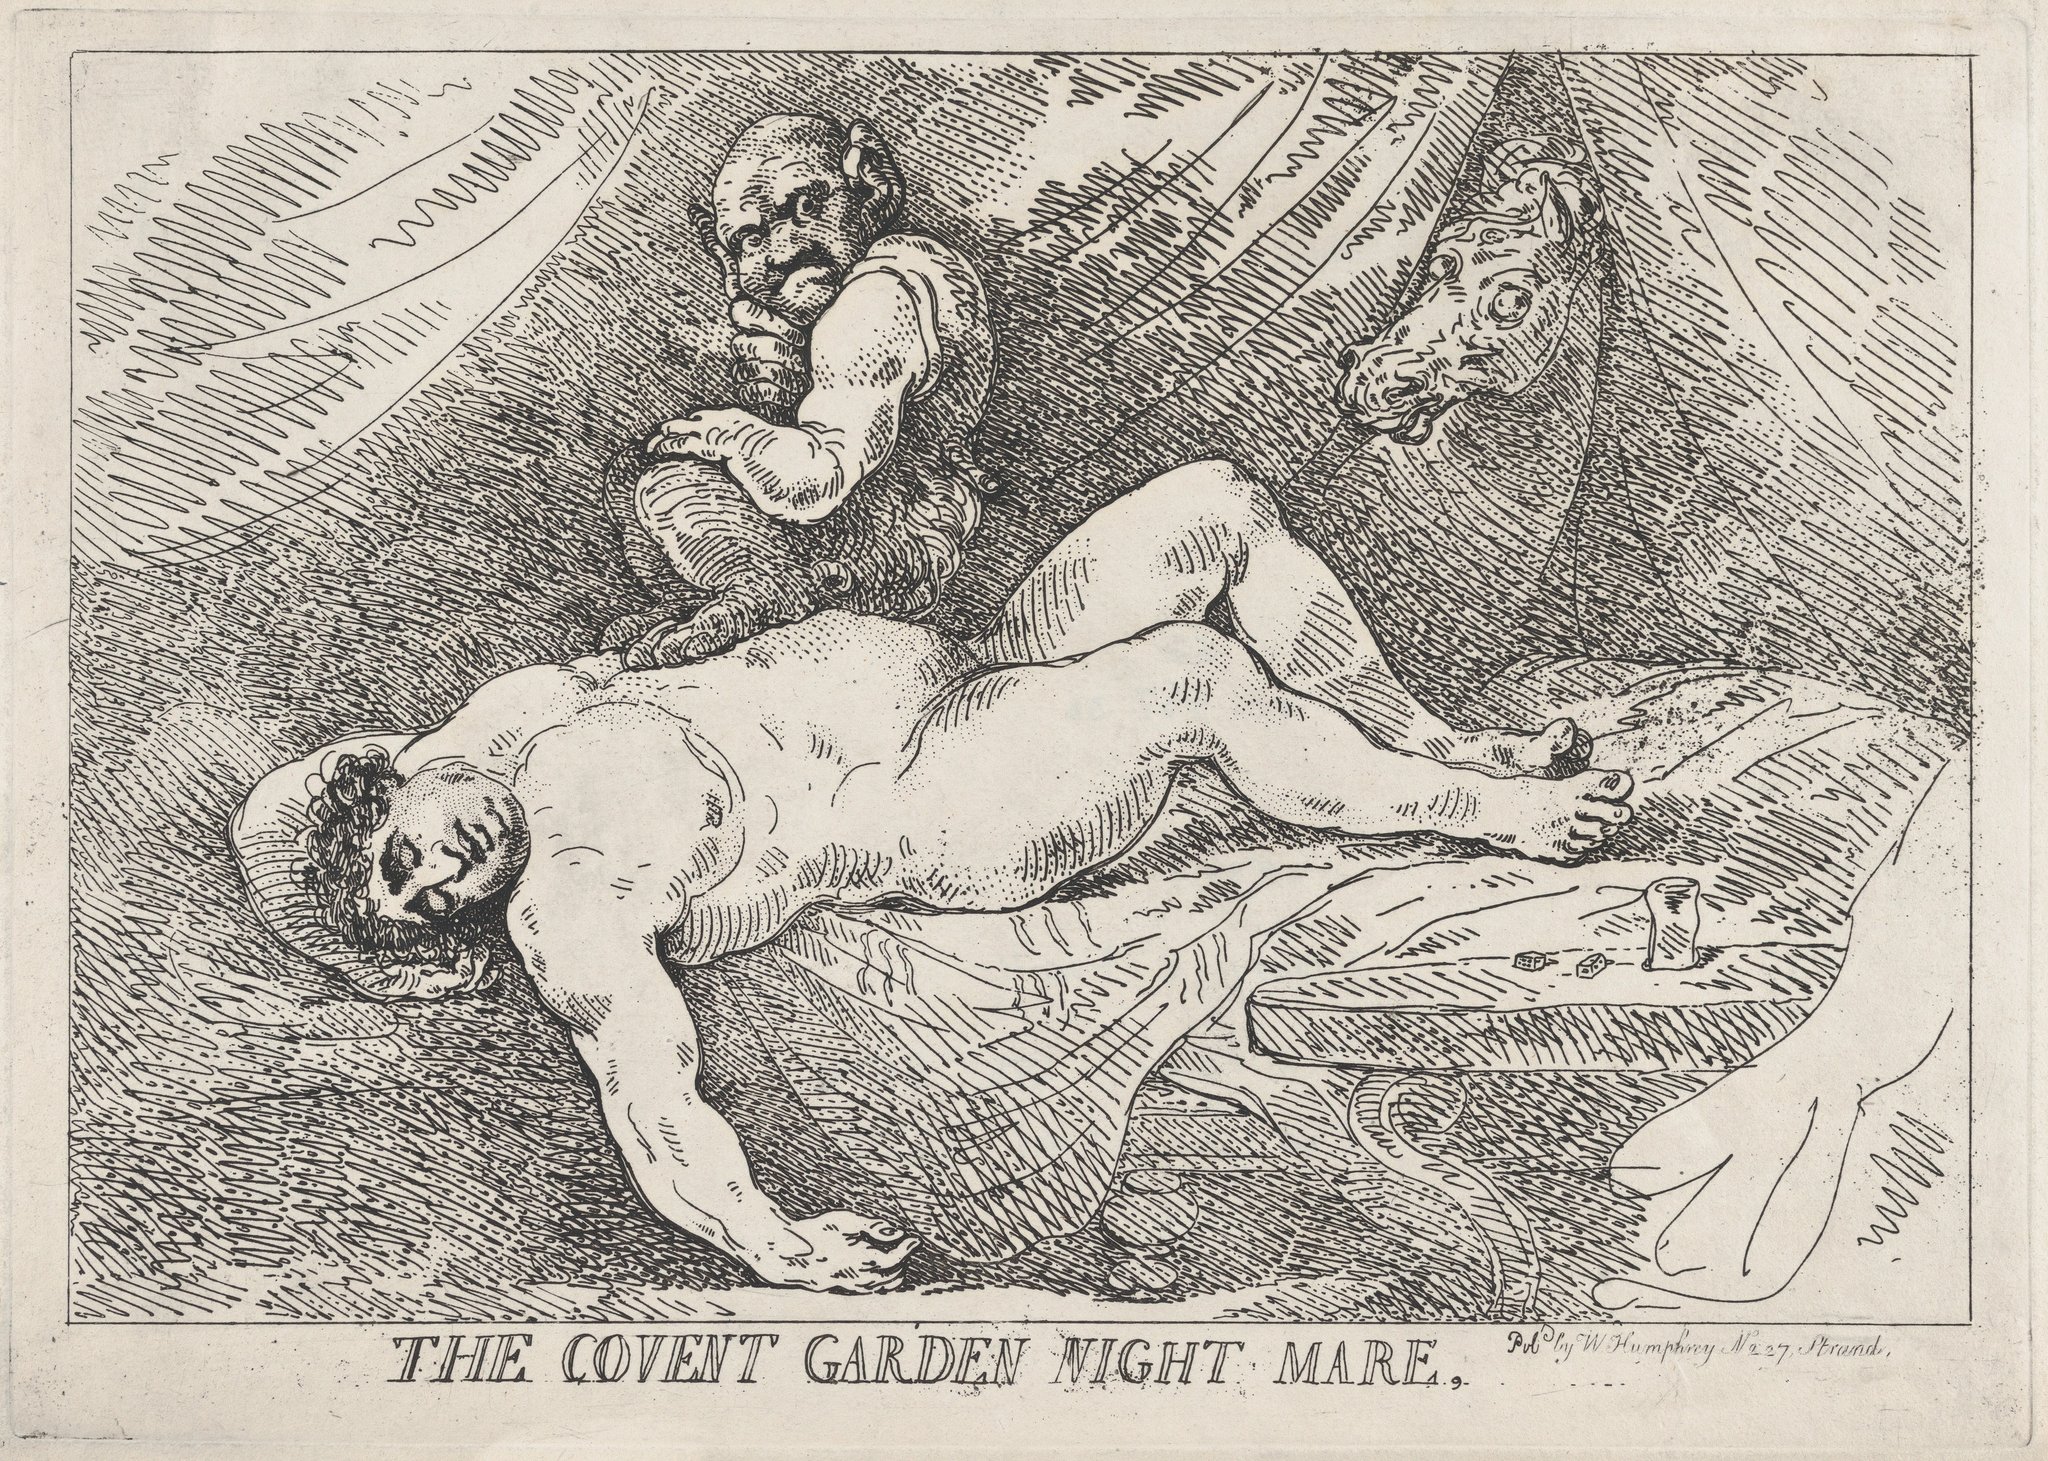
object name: print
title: The Covent Garden Night Mare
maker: thomas rowlandson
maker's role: artist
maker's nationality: british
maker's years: 1757-1827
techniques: etching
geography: london